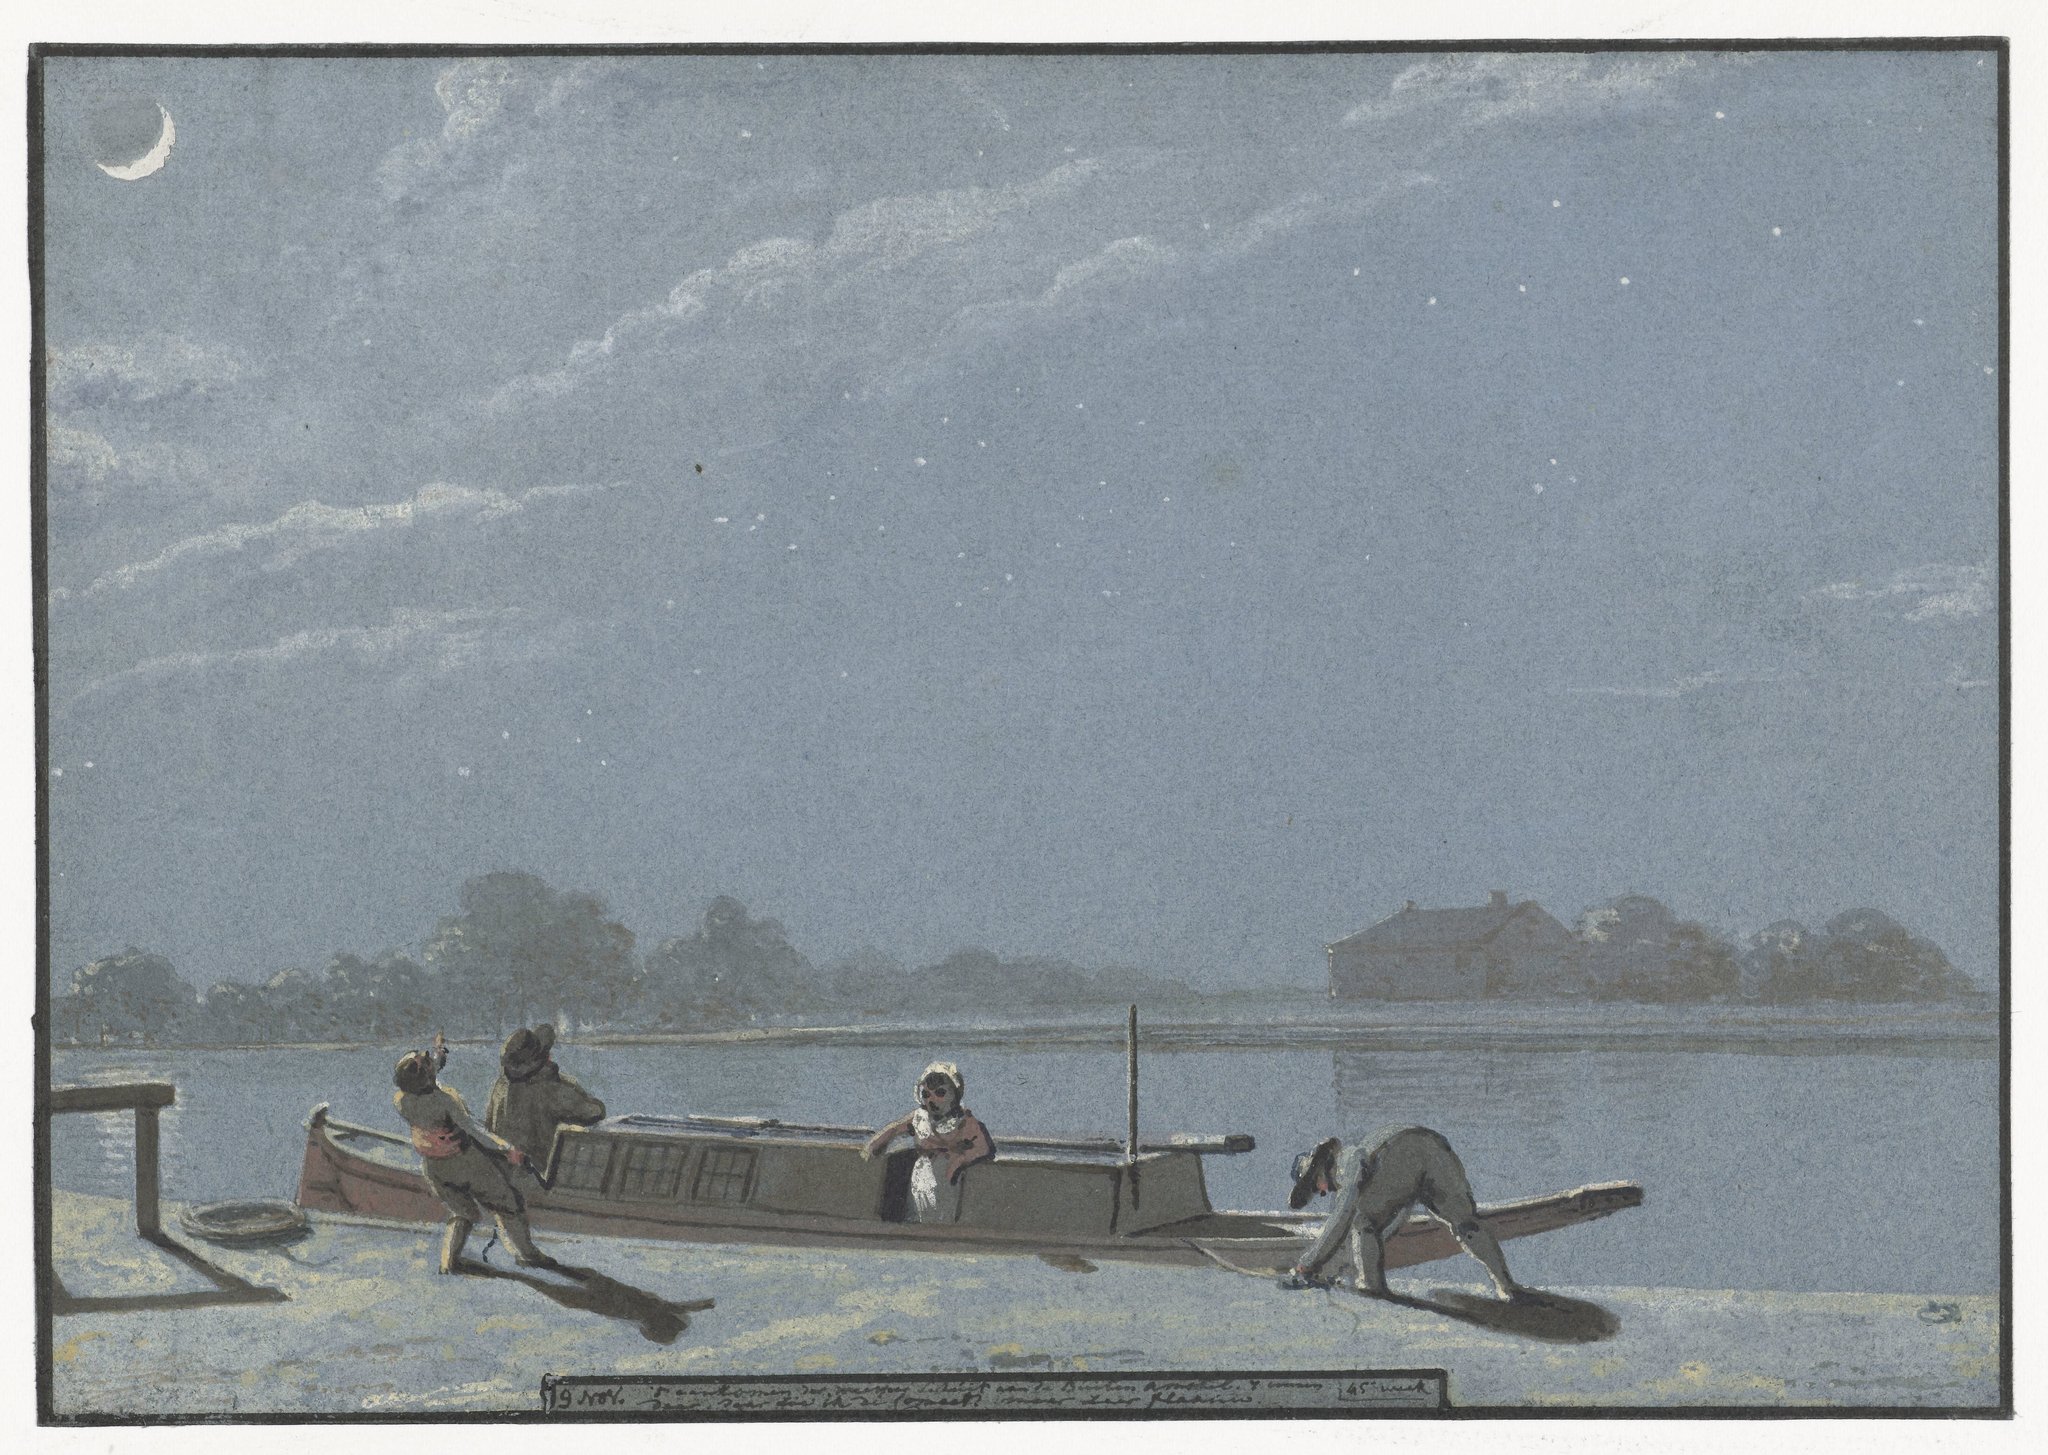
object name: drawing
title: ‘The Weesper Boat Pulling in at Buiten Amstel’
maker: christiaan andriessen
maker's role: draughtsman, print maker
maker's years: 1775-1846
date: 1805-1808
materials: paint, paper, watercolor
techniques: brush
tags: comet, stars in the firmament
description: It is early evening. A starry canopy extends over the Amstel River, just outside the city. The man helping moor the boat at the left points to the barely visible comet referred to in the caption. In this drawing Andriessen is less interested in the astronomical phenomenon and more in the effect of the bright moonlight on the clouds, the river, and its surroundings.